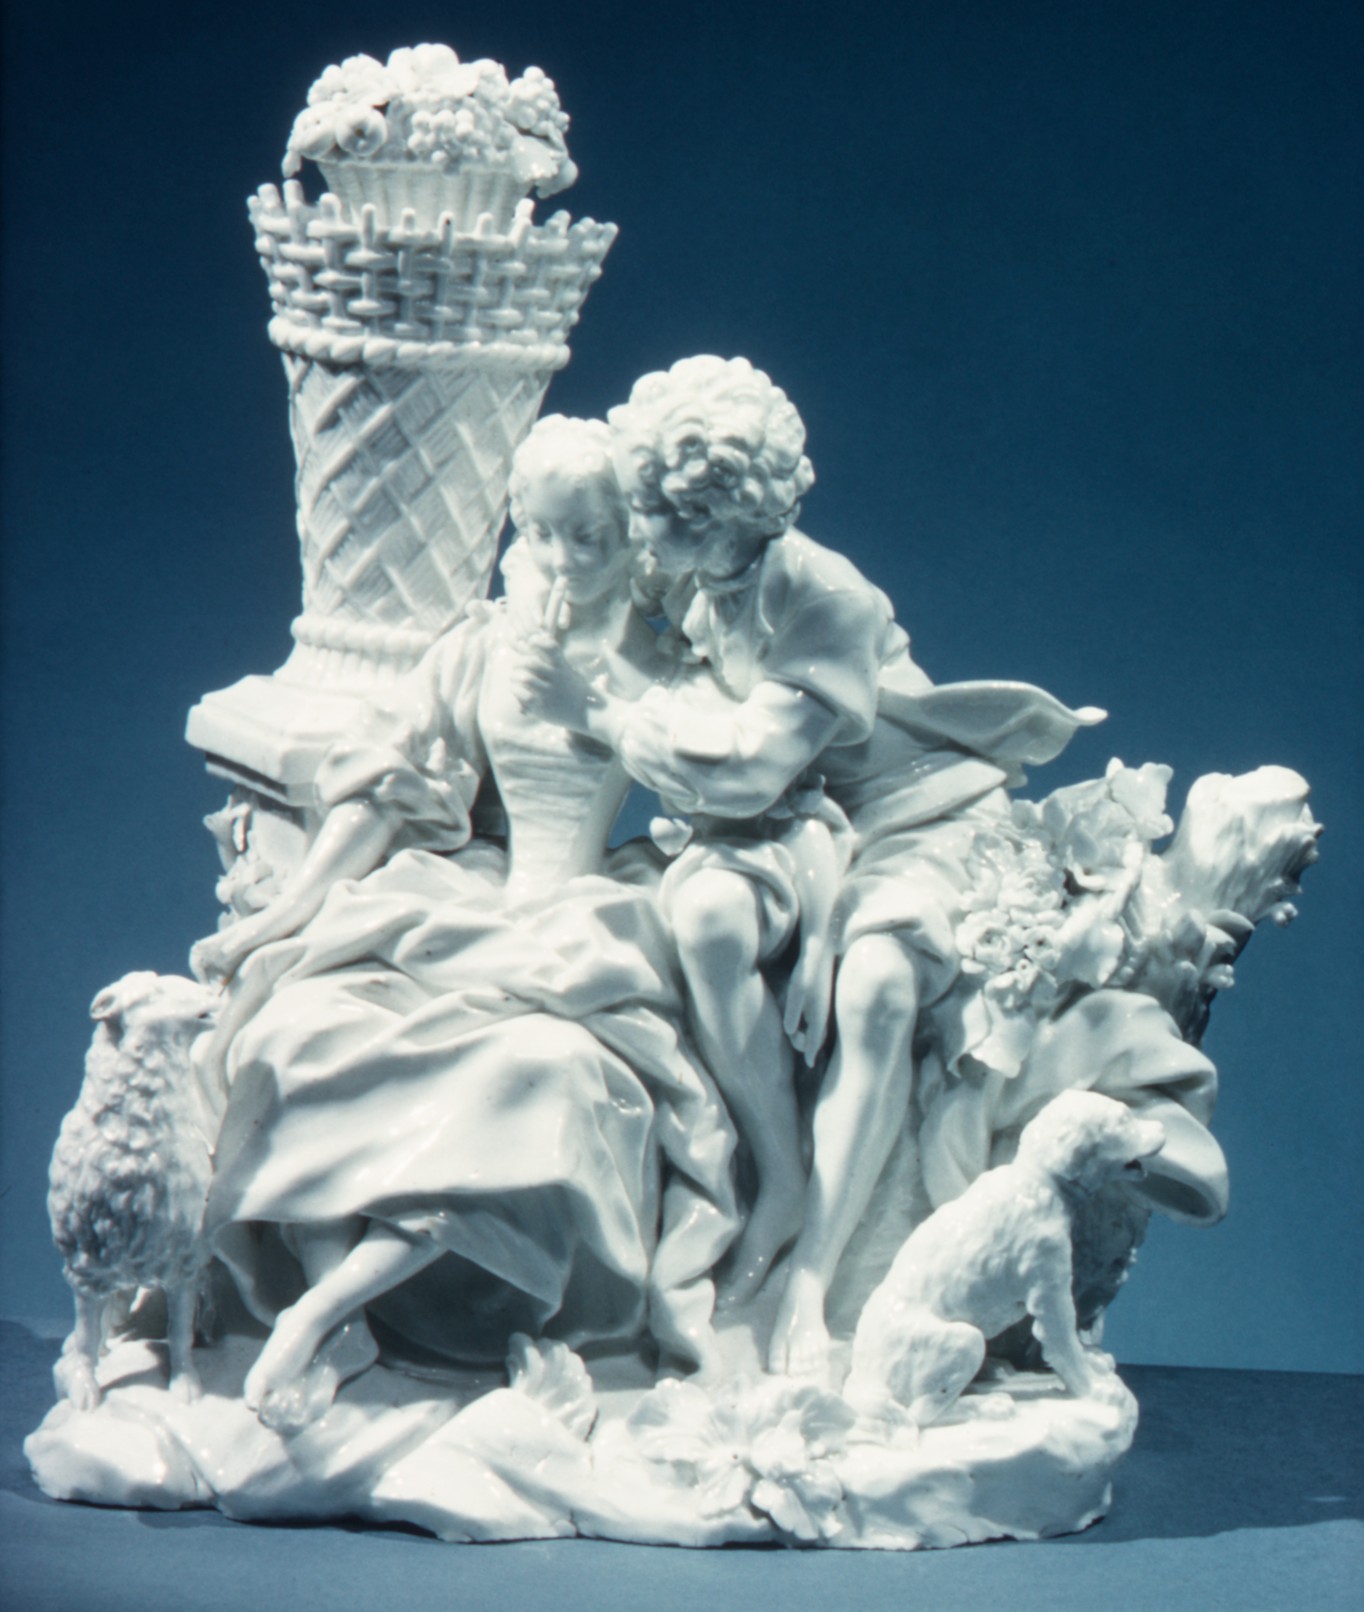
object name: group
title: The Flute Lesson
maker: vincennes manufactory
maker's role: manufactory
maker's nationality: french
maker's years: 1740-1756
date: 1752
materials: soft paste porcelain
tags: animals,men,women,flutes